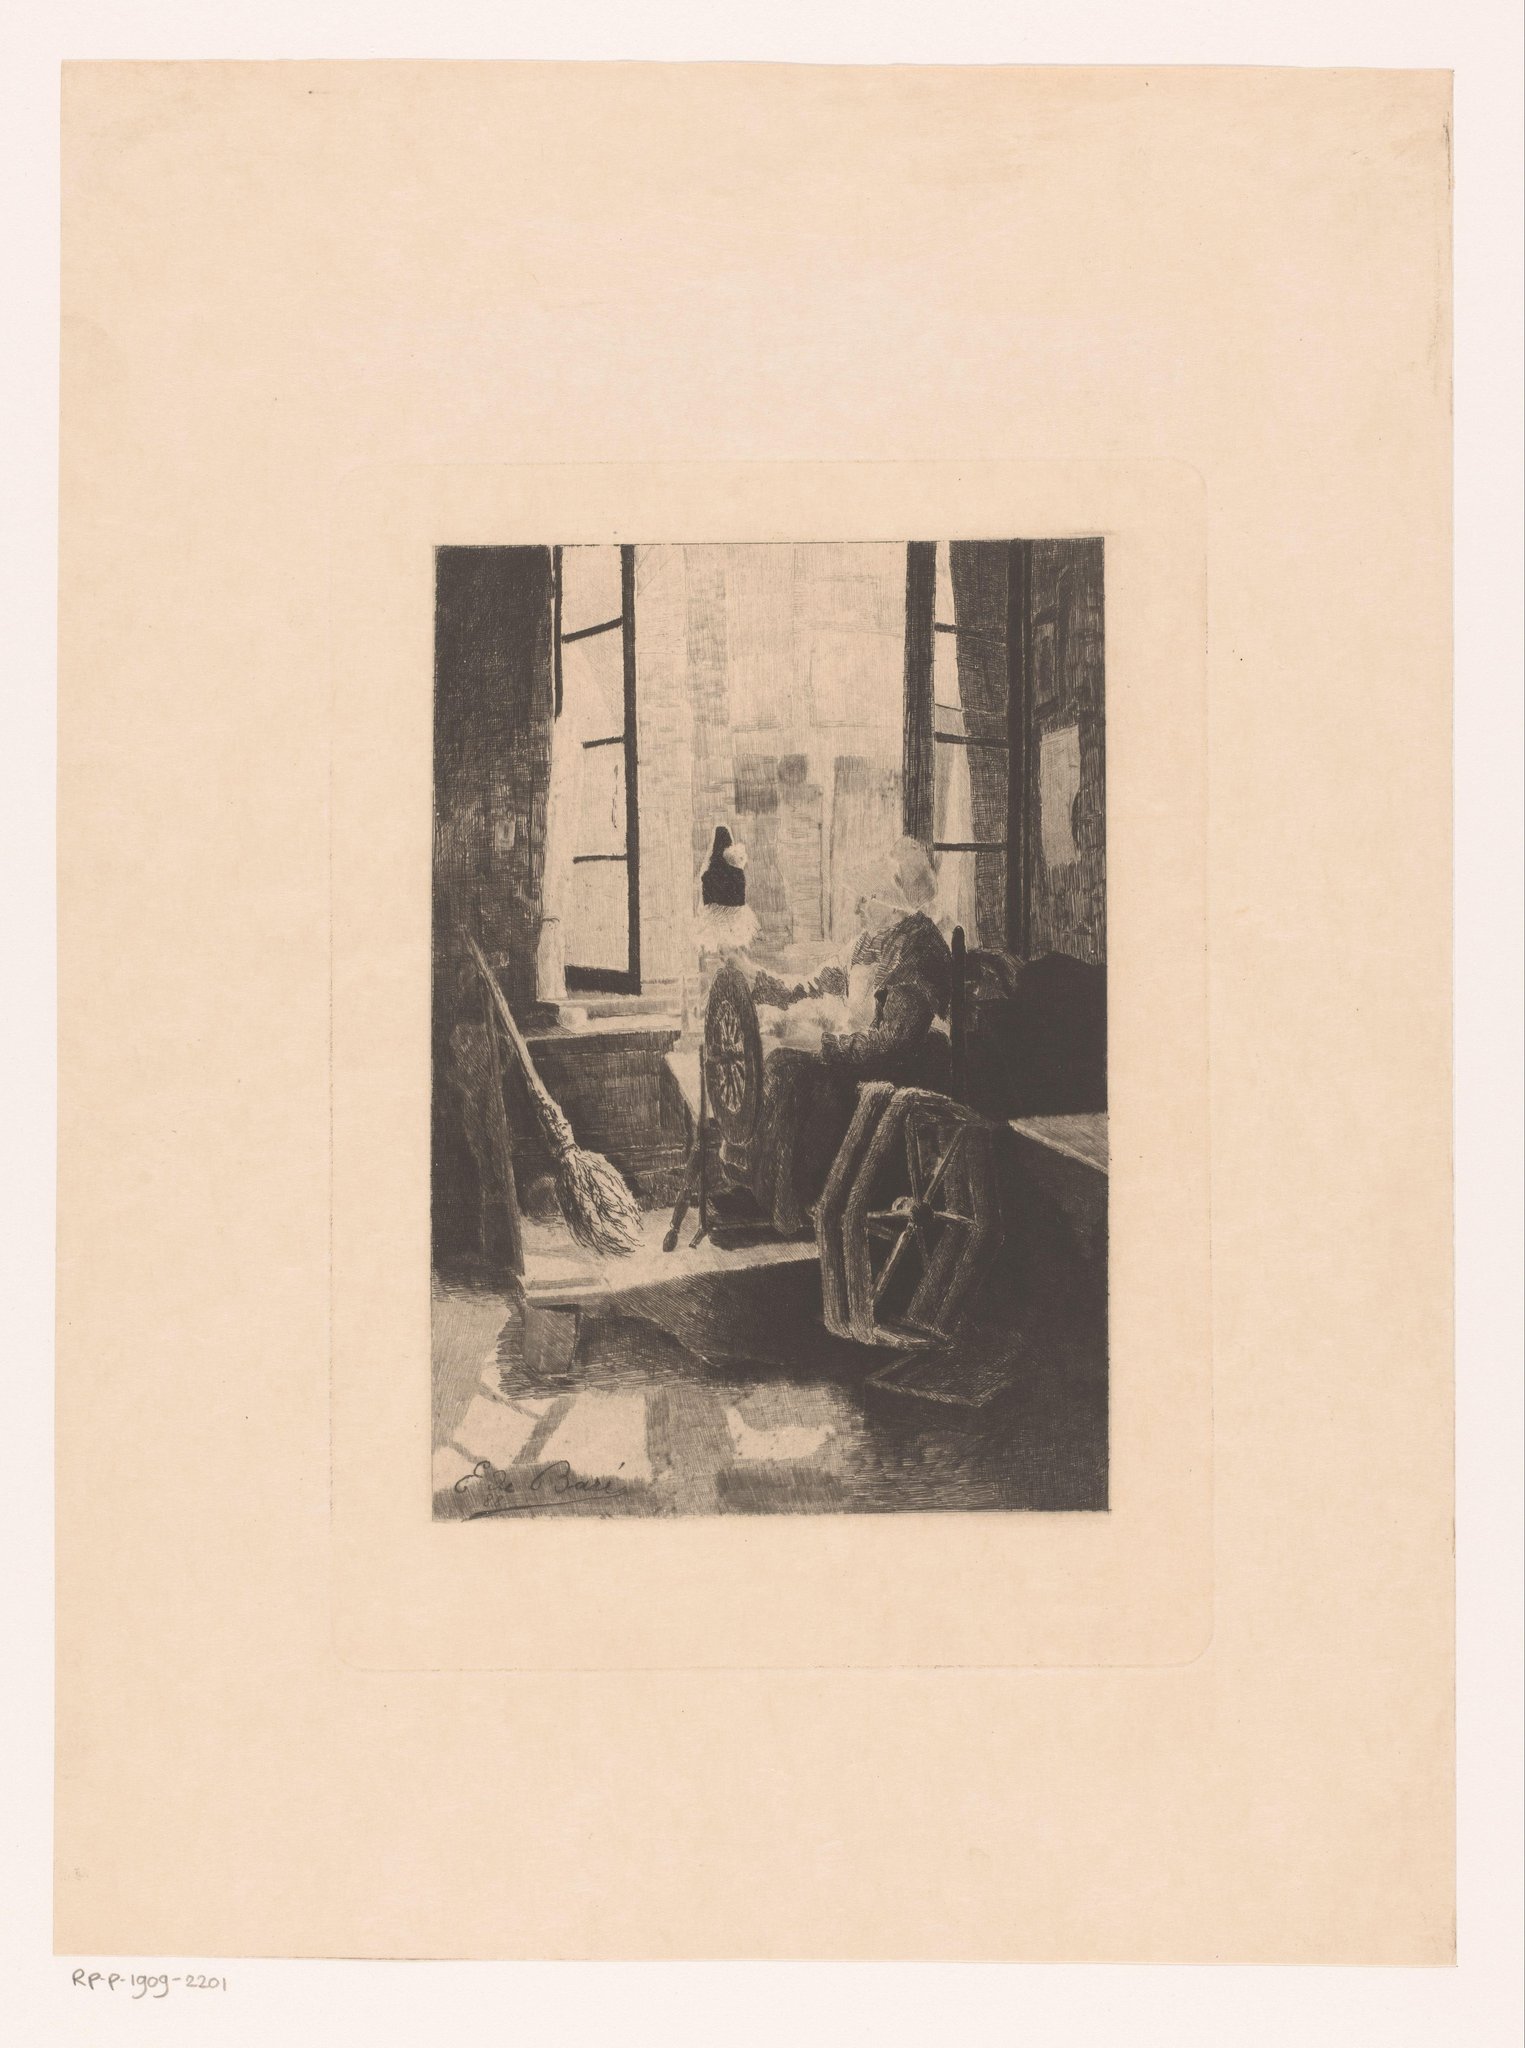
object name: print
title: Vrouw aan een spinnewiel bij een open raam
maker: emile de baré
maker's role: painter, print maker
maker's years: 1855-1902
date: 1888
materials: paper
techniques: etching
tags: spinning-wheel, interior of the house, open window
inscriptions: collector's mark: Lugt 2228